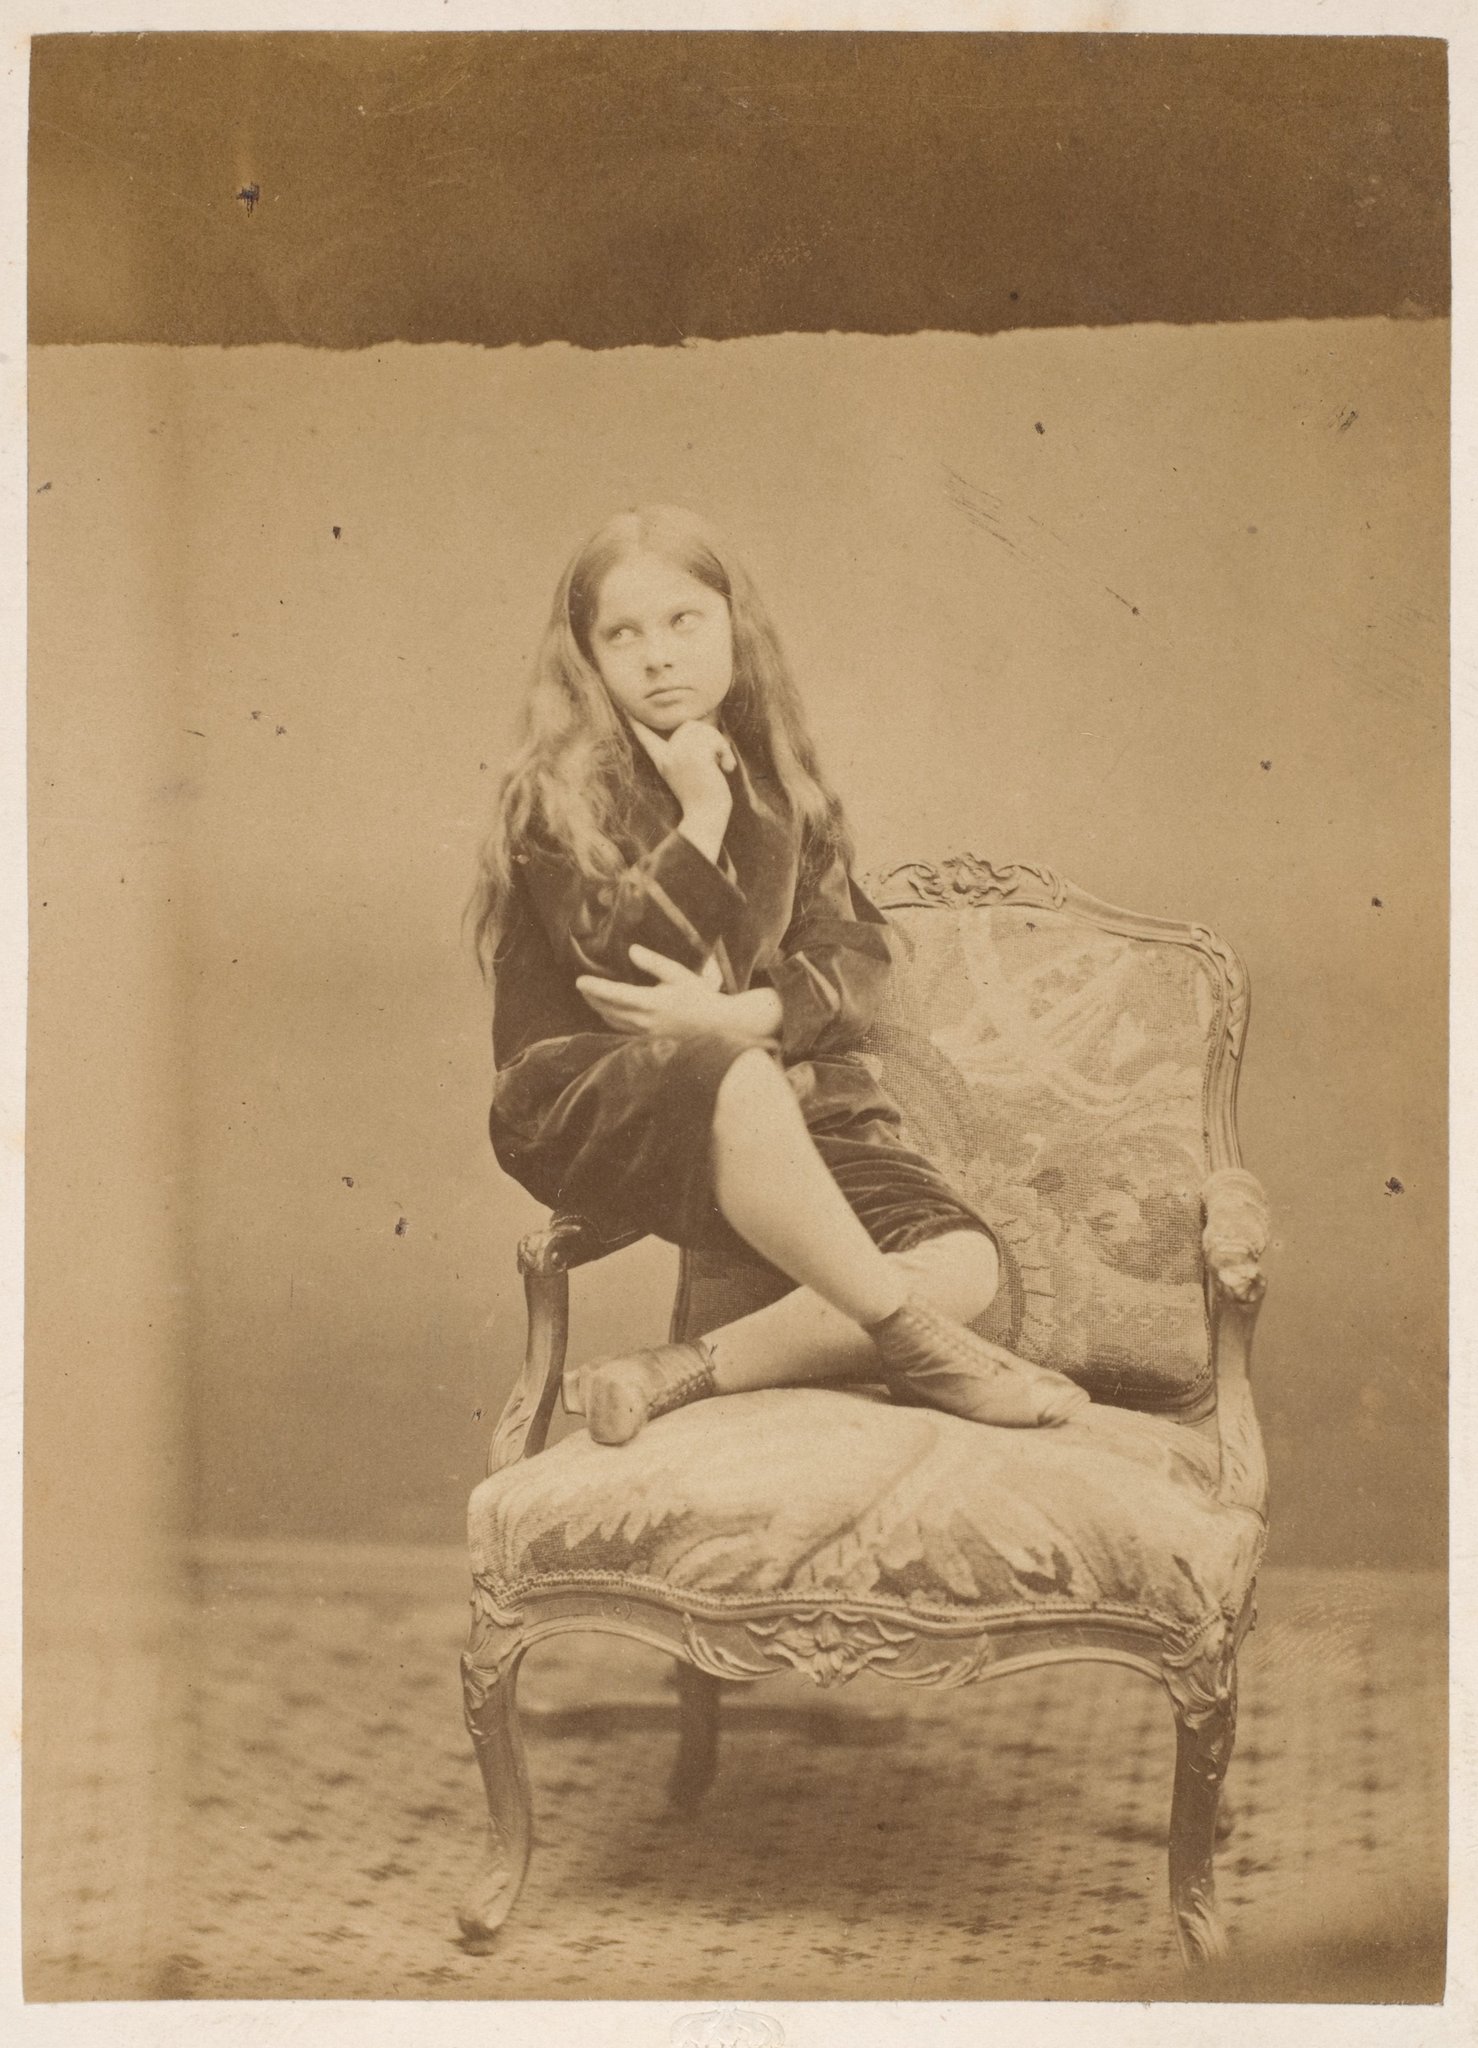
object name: photograph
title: Les jambes croisées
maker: pierre-louis pierson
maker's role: artist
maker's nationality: french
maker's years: 1822-1913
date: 1860-1869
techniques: albumen silver print, glass negative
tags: girls,portraits